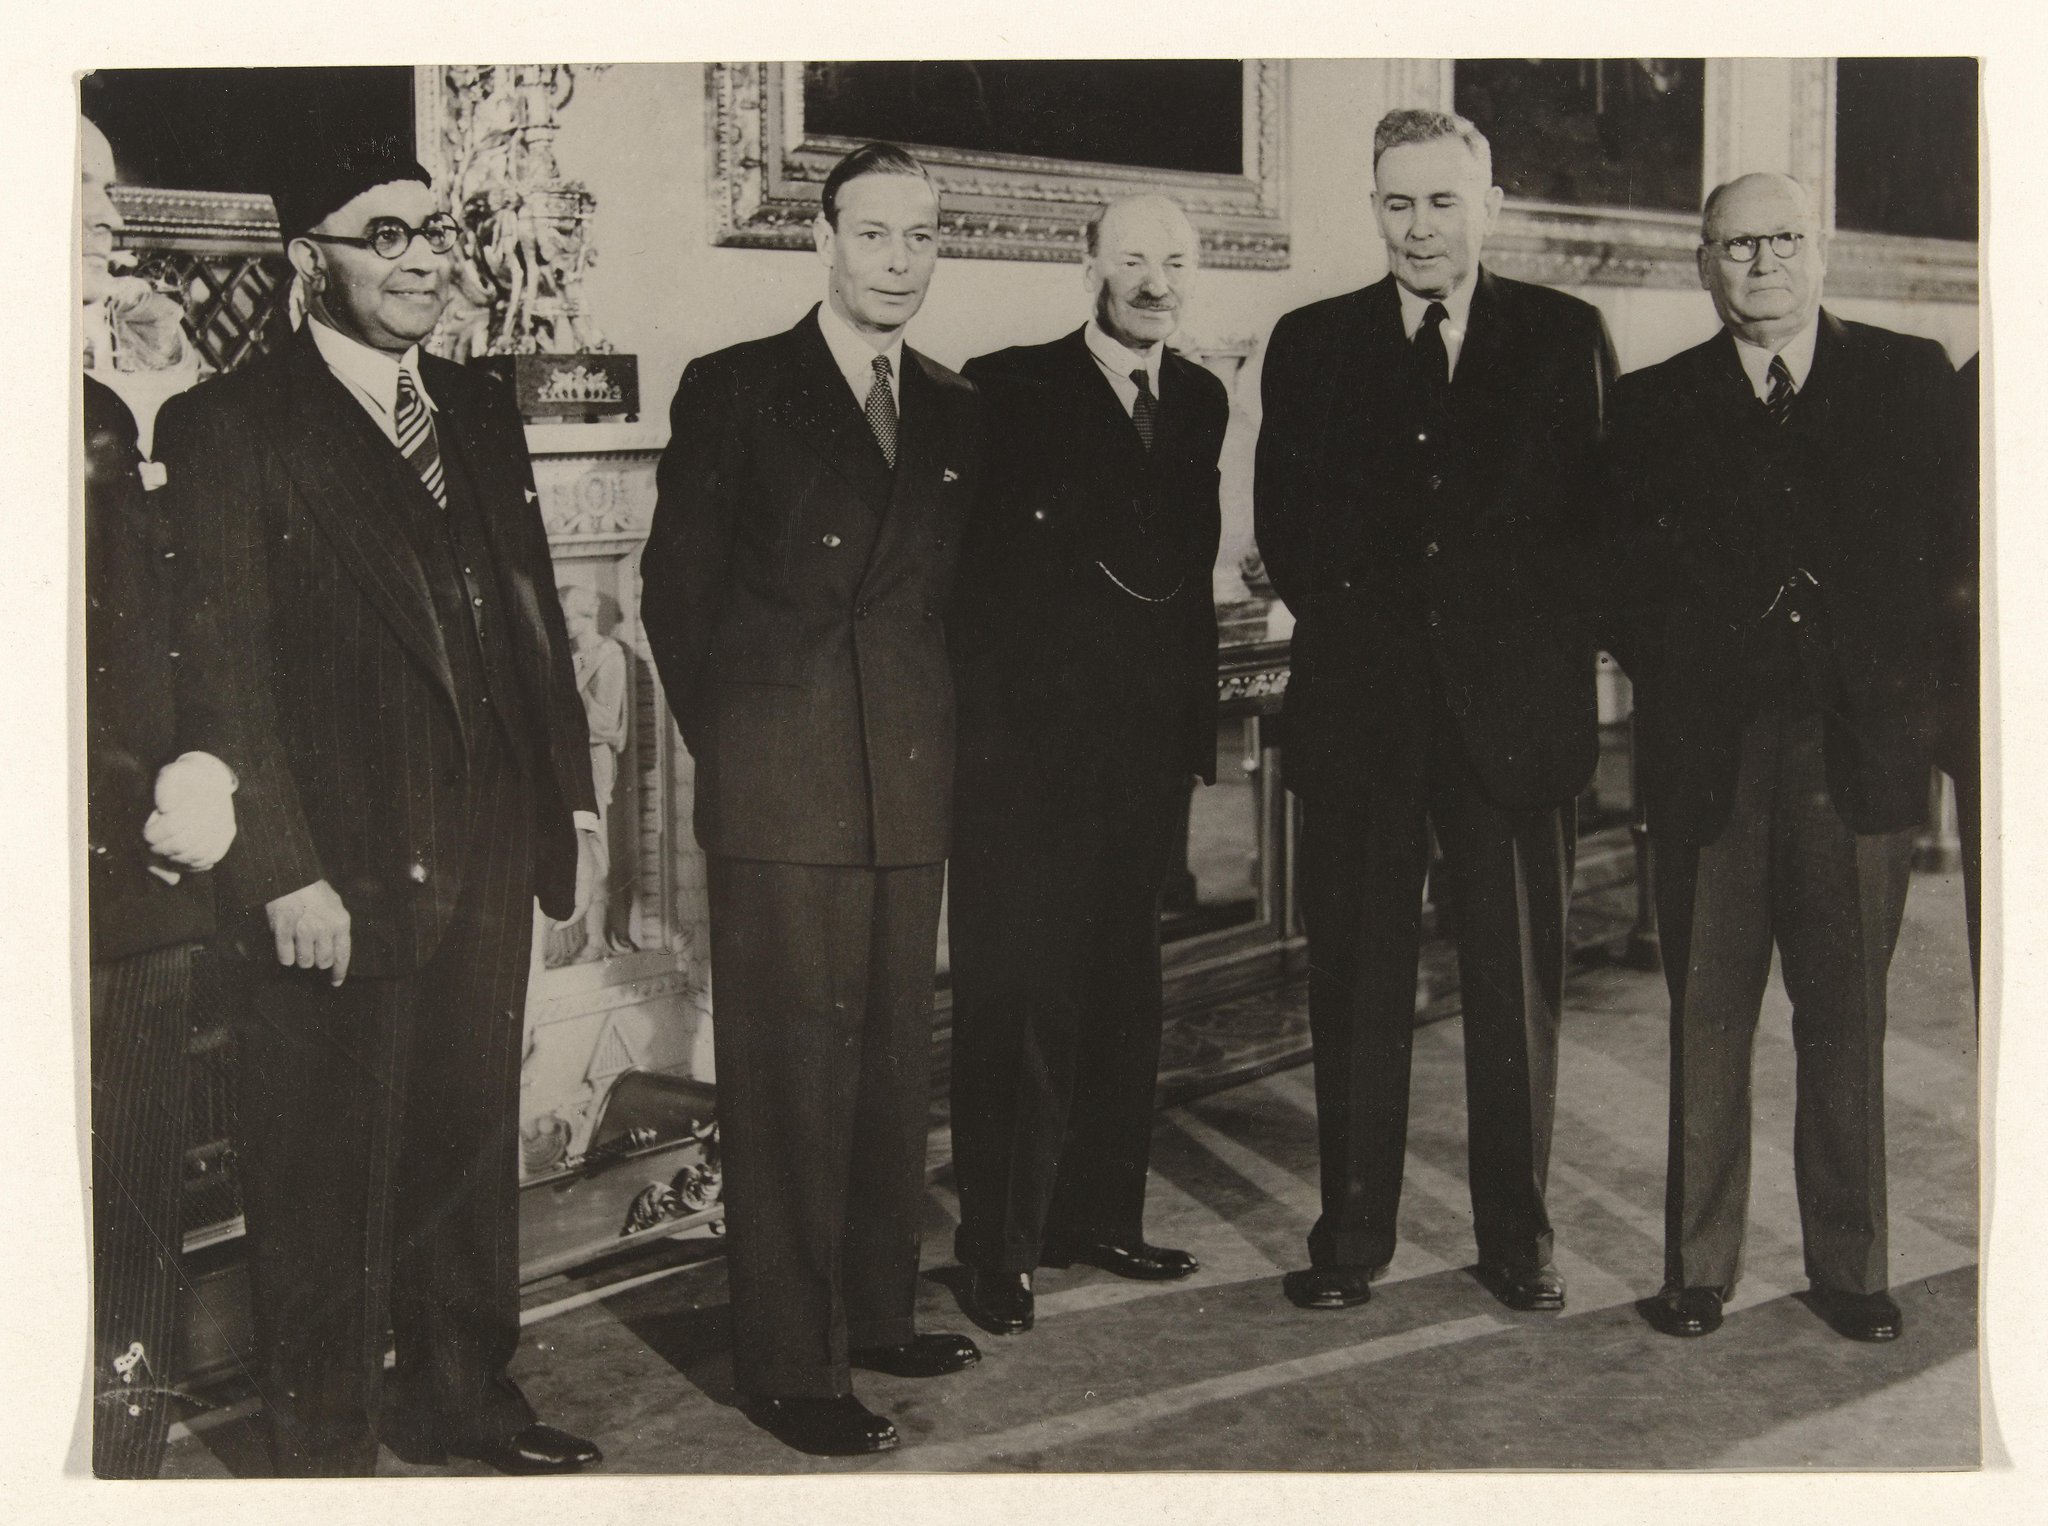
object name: photograph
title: Minister presidenten Attlee, Ali Khan, Chifley en Malan op bezoek bij koning George VI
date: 1949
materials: photographic support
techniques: gelatin silver print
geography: london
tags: politician